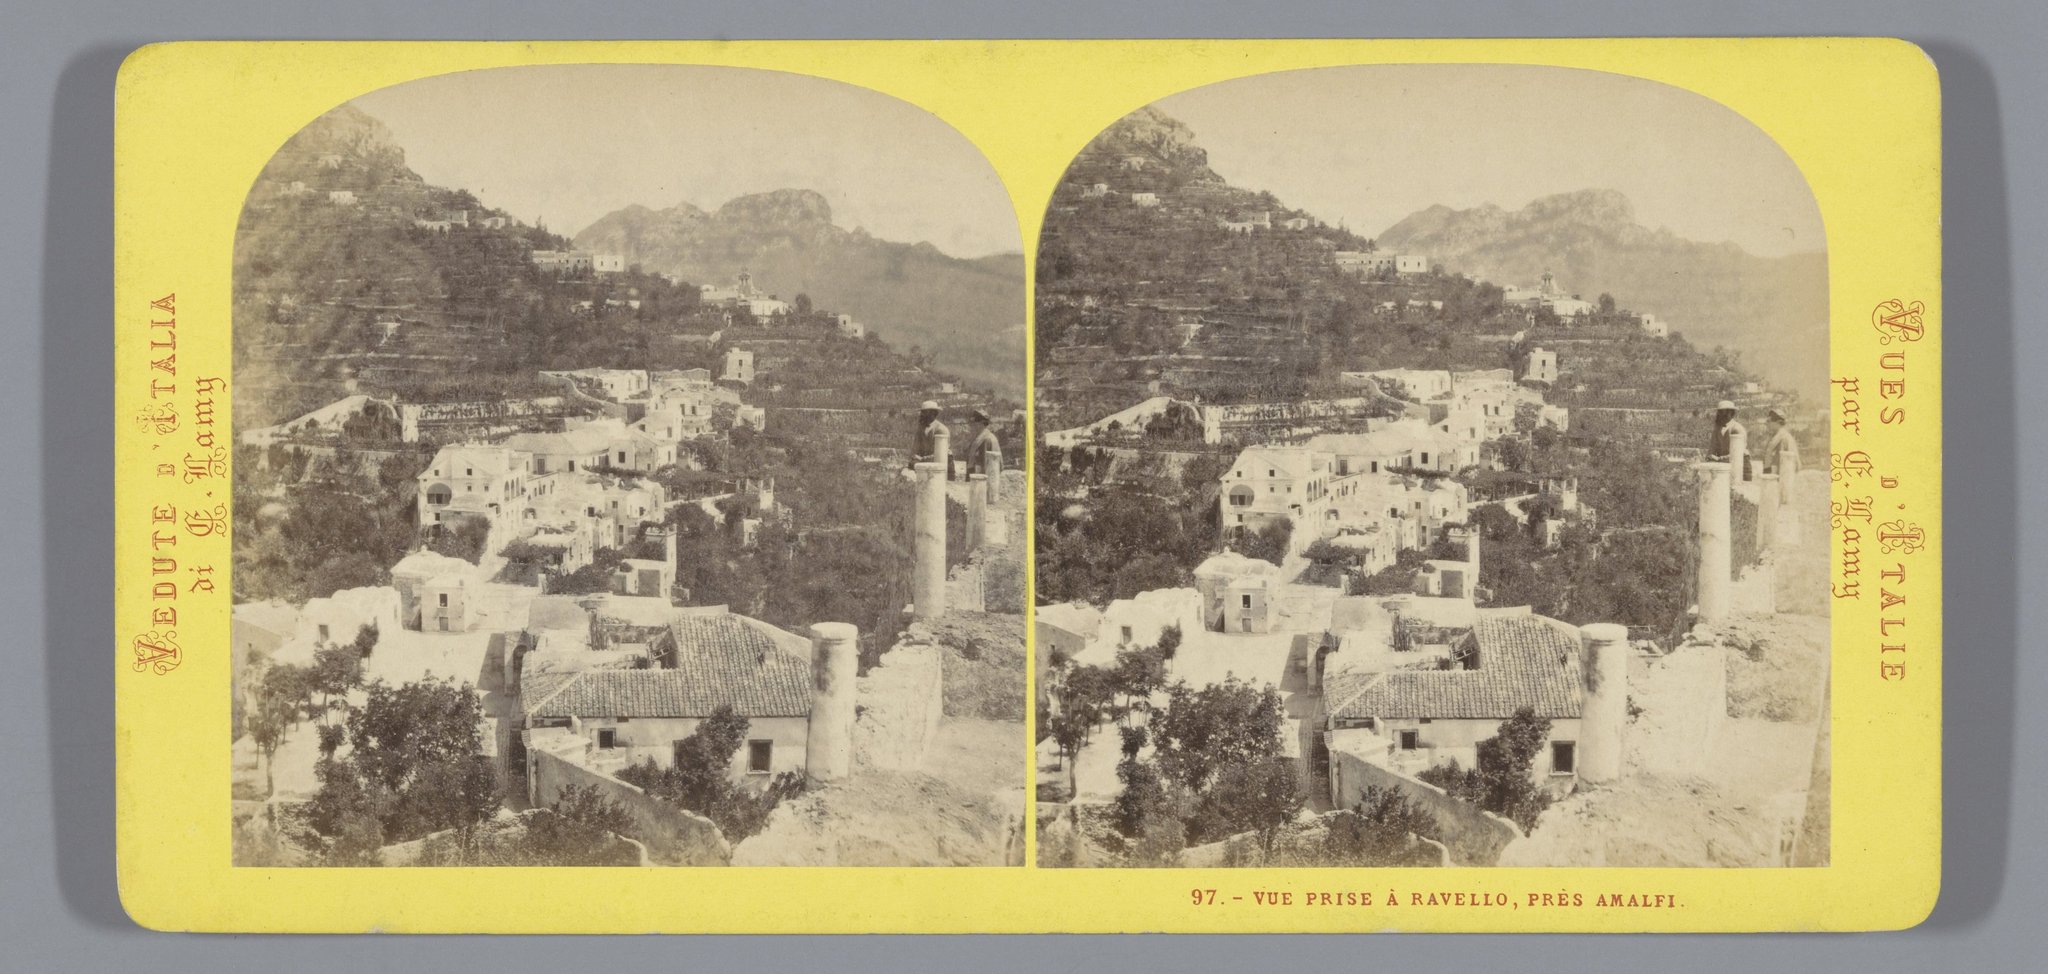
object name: stereograph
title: Vue prise à Ravello, près Amalfi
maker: ernest eléonor pierre lamy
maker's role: publisher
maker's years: 1828-1900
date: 1861-1878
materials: cardboard, paper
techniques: albumen print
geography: ravello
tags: prospect of village, silhouette of village, (high) hill, ravello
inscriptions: number: ‘97.’